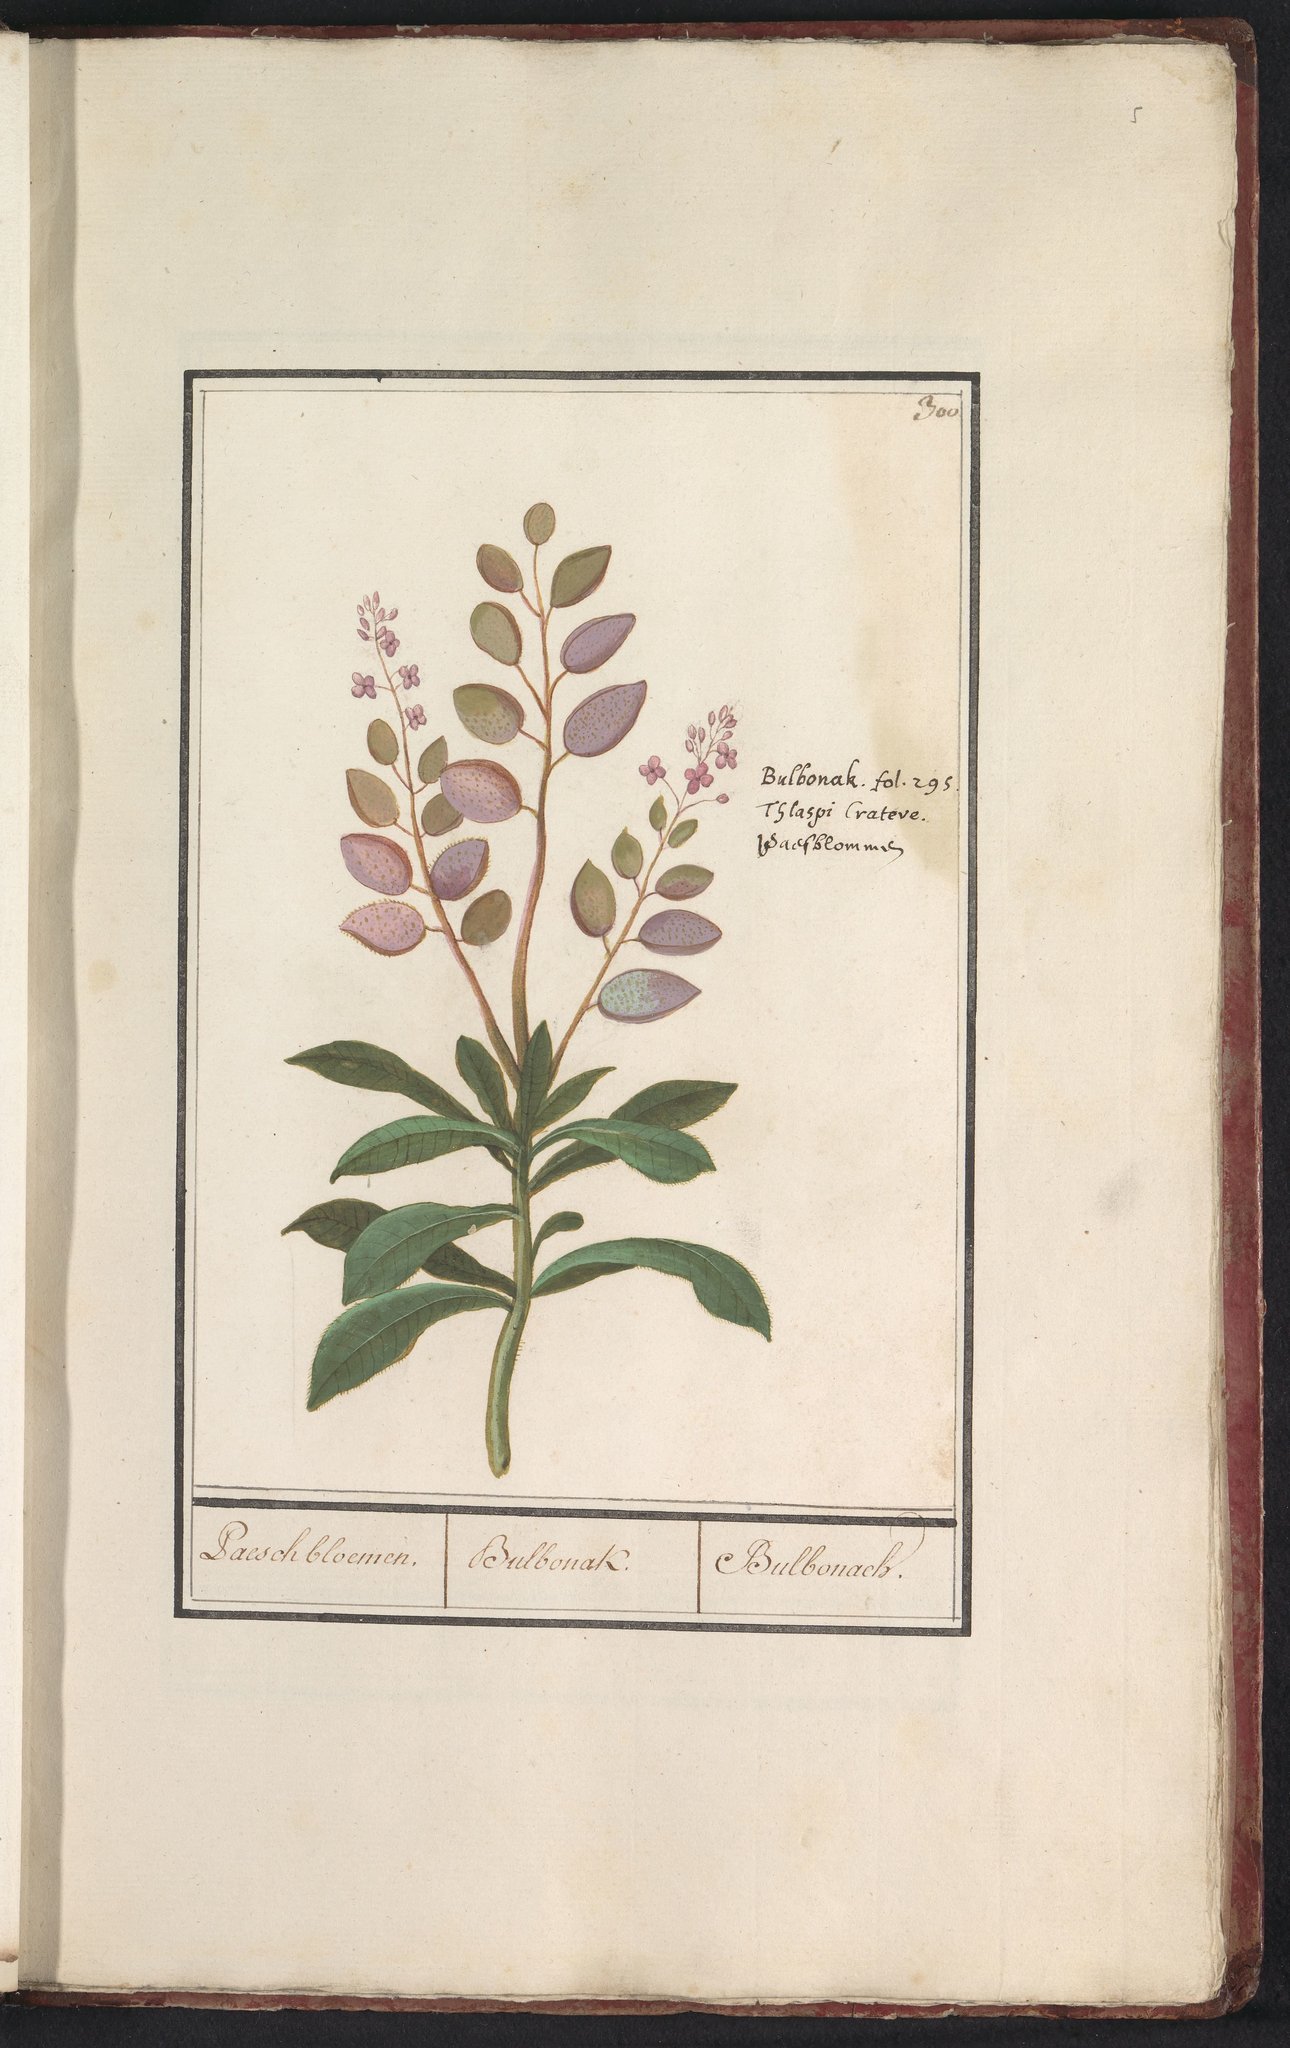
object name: drawing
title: Judaspenning (Lunaria annua)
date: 1596-1610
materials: chalk, paint, ink, paper, watercolor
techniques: brush, pen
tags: flowers: honesty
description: Judaspenning. Genummerd rechtsboven: 300. Rechts de naam in drie talen. Onderdeel van het vierde album met tekeningen van bloemen en paddestoelen. Elfde van twaalf albums met tekeningen van dieren, vogels en planten bekend rond 1600, gemaakt in opdracht van keizer Rudolf II. Met toelichting in Nederlands, Latijn en Frans.